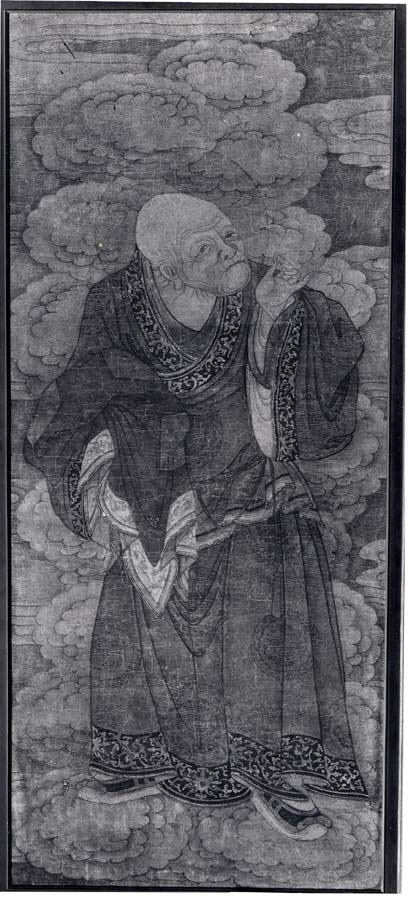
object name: painting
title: An Arhat in the Clouds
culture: chinese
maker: unidentified artist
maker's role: artist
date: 1501-1600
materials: ink, paper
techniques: painting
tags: men,clouds,buddhism